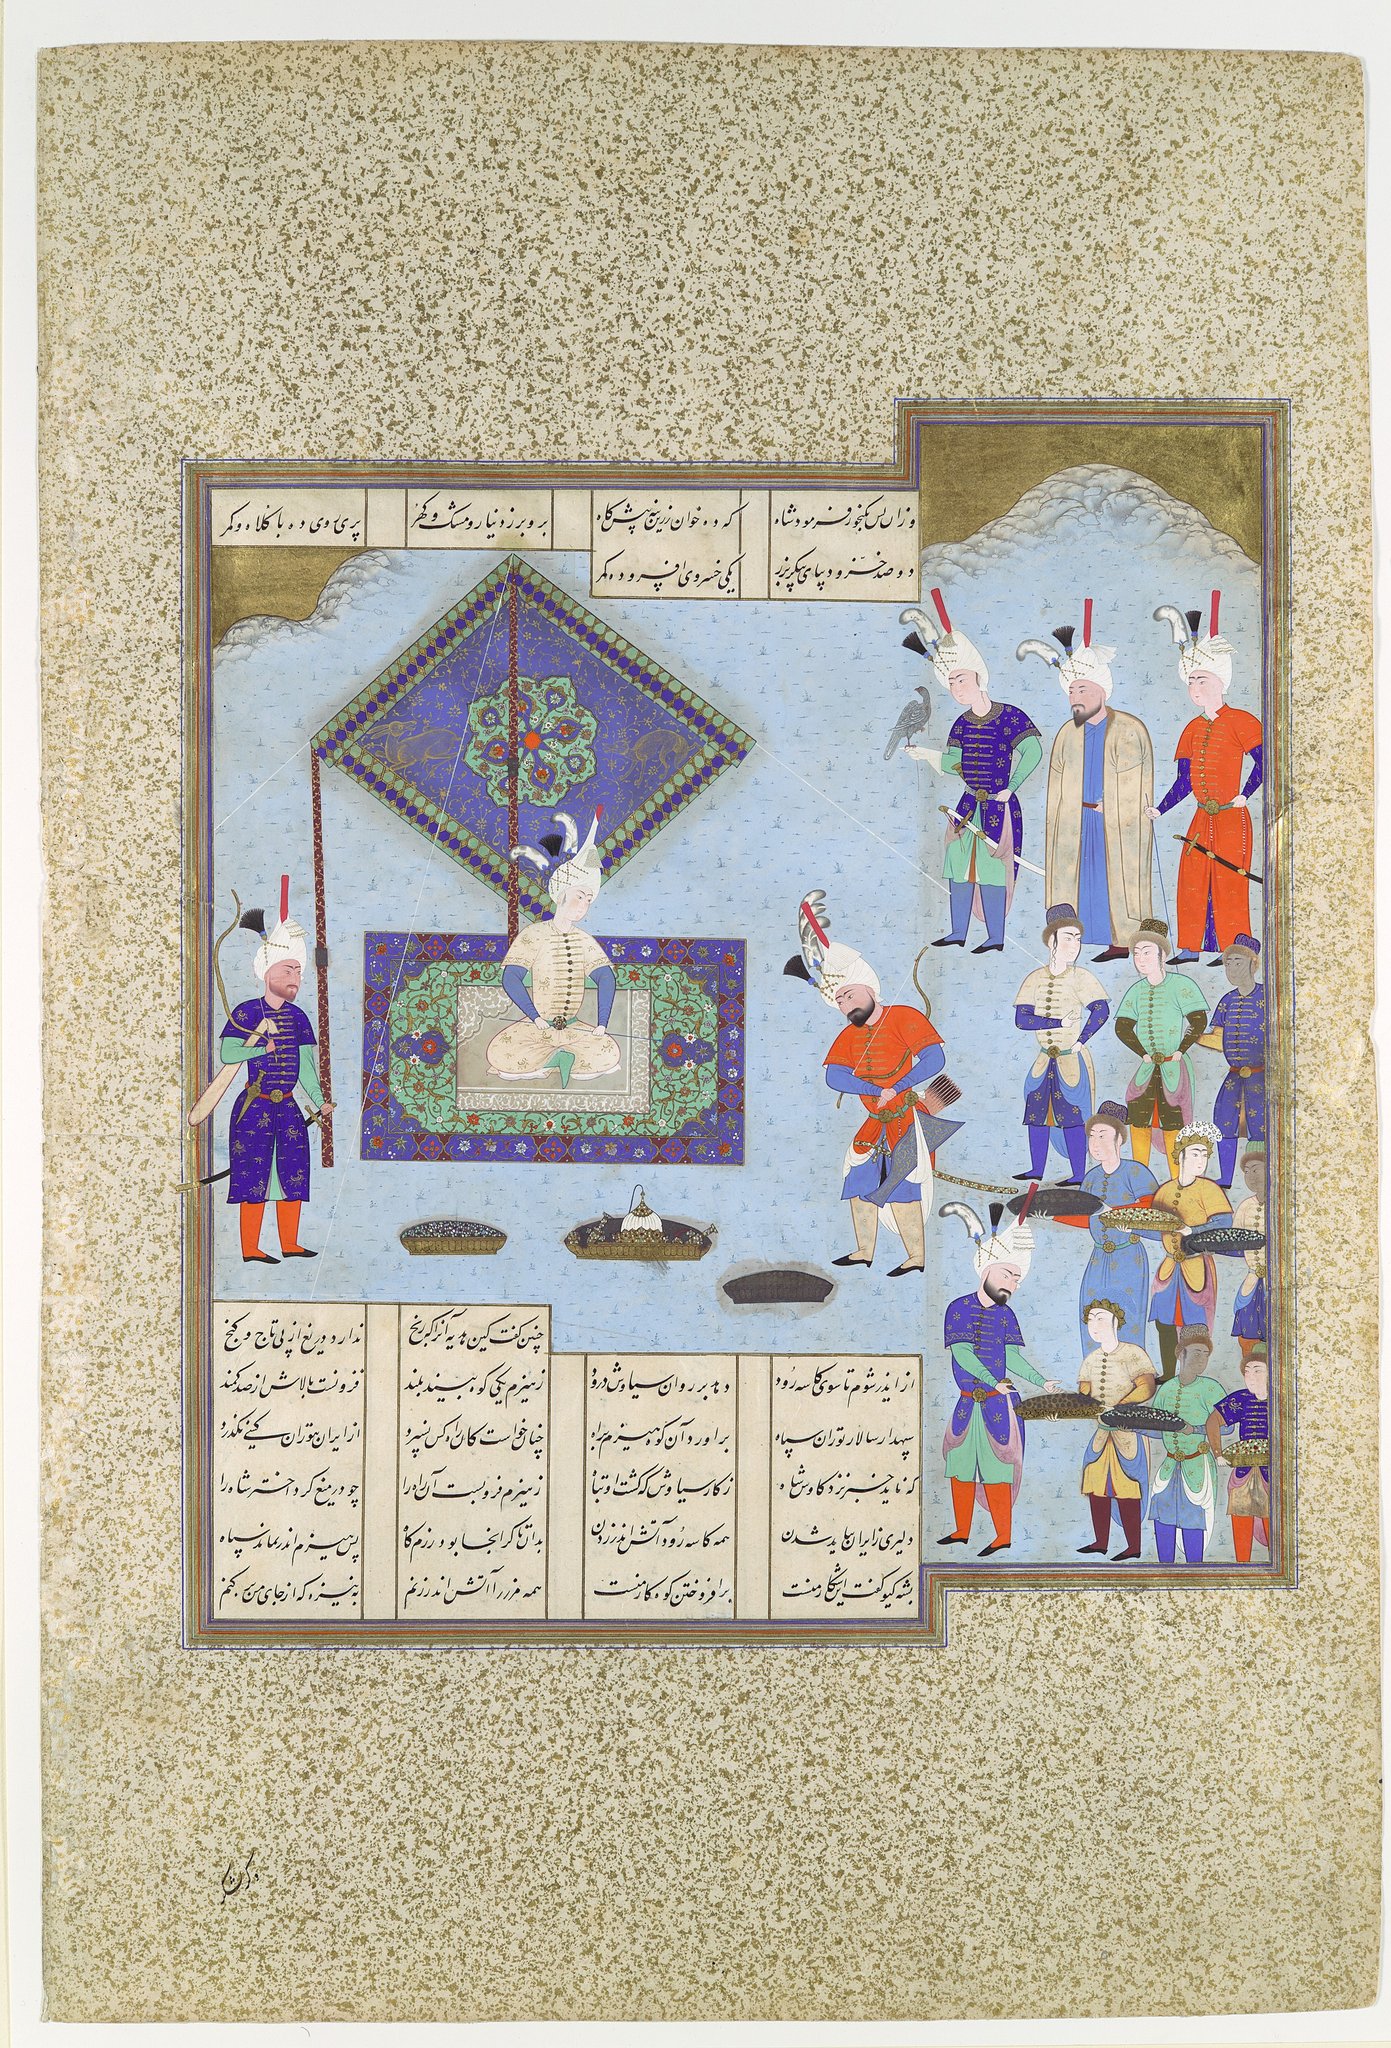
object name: folio from an illustrated manuscript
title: "Kai Khusrau's War Prizes Are Pledged", Folio 225v from the Shahnama (Book of Kings) of Shah Tahmasp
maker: abu'l qasim firdausi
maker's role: author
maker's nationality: iranian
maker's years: 935-1020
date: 1530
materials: gold, ink, paper, silver, watercolor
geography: iran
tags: poetry,men